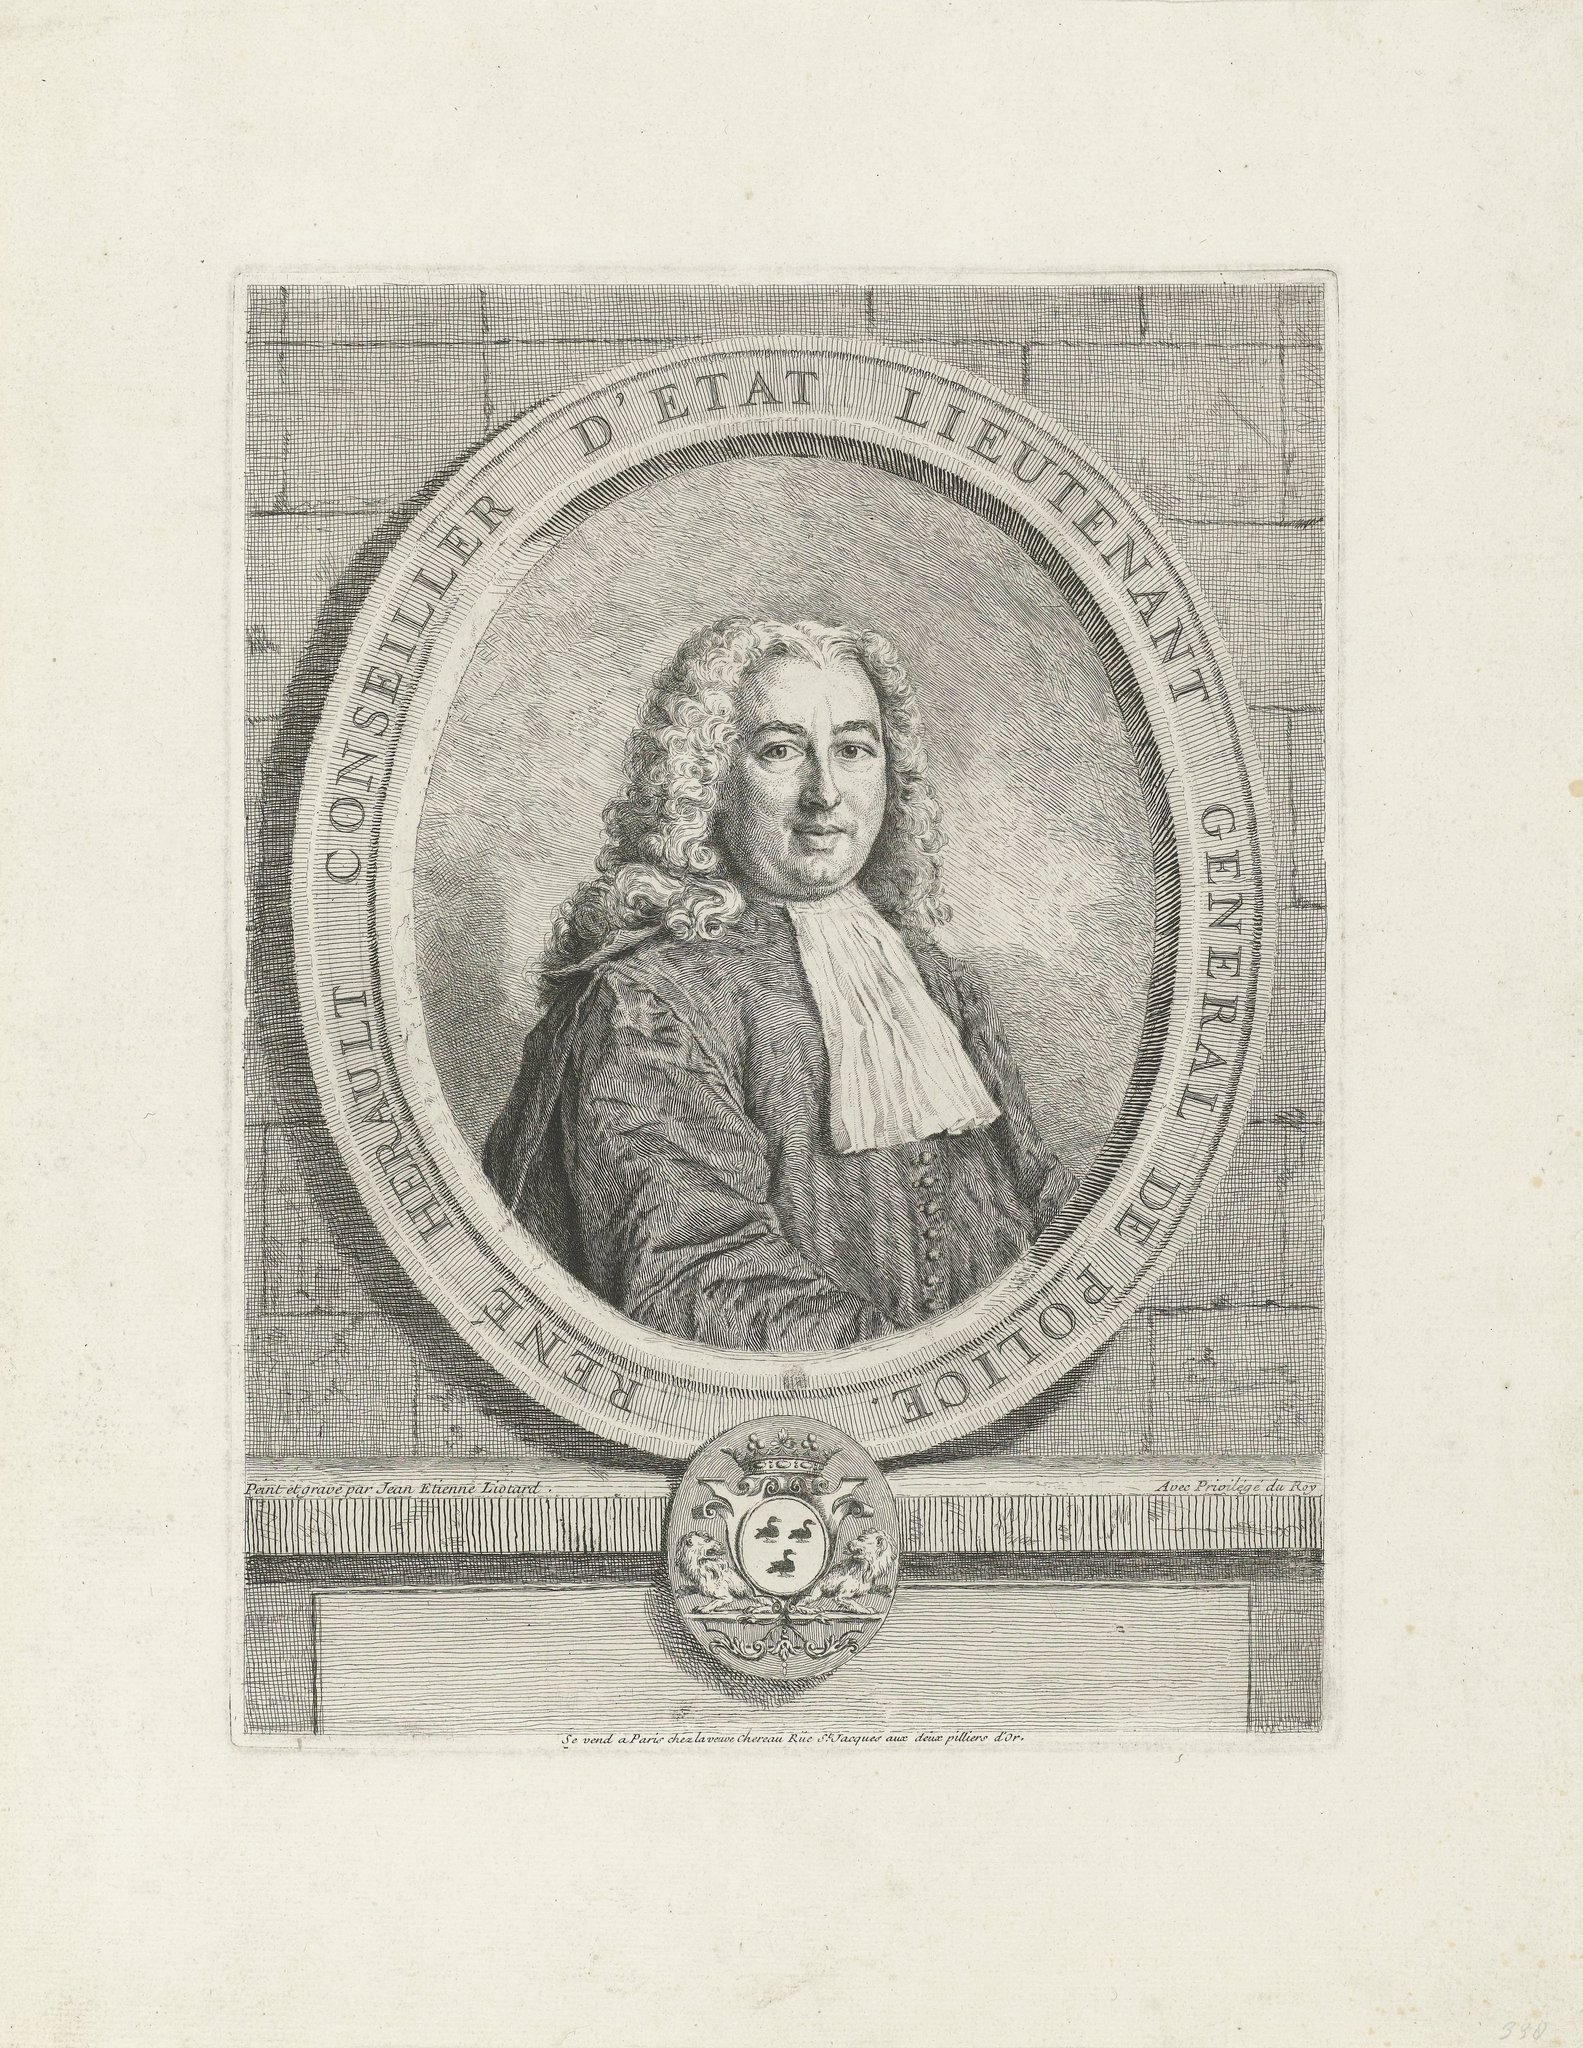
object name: print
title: Portret van René Hérault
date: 1730-1735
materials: paper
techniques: engraving, etching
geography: paris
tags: rouen, rené hérault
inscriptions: collector's mark: Lugt 240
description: Portret van René Herault in een ovale omlijsting met tekst. Onderaan een wapenschild.